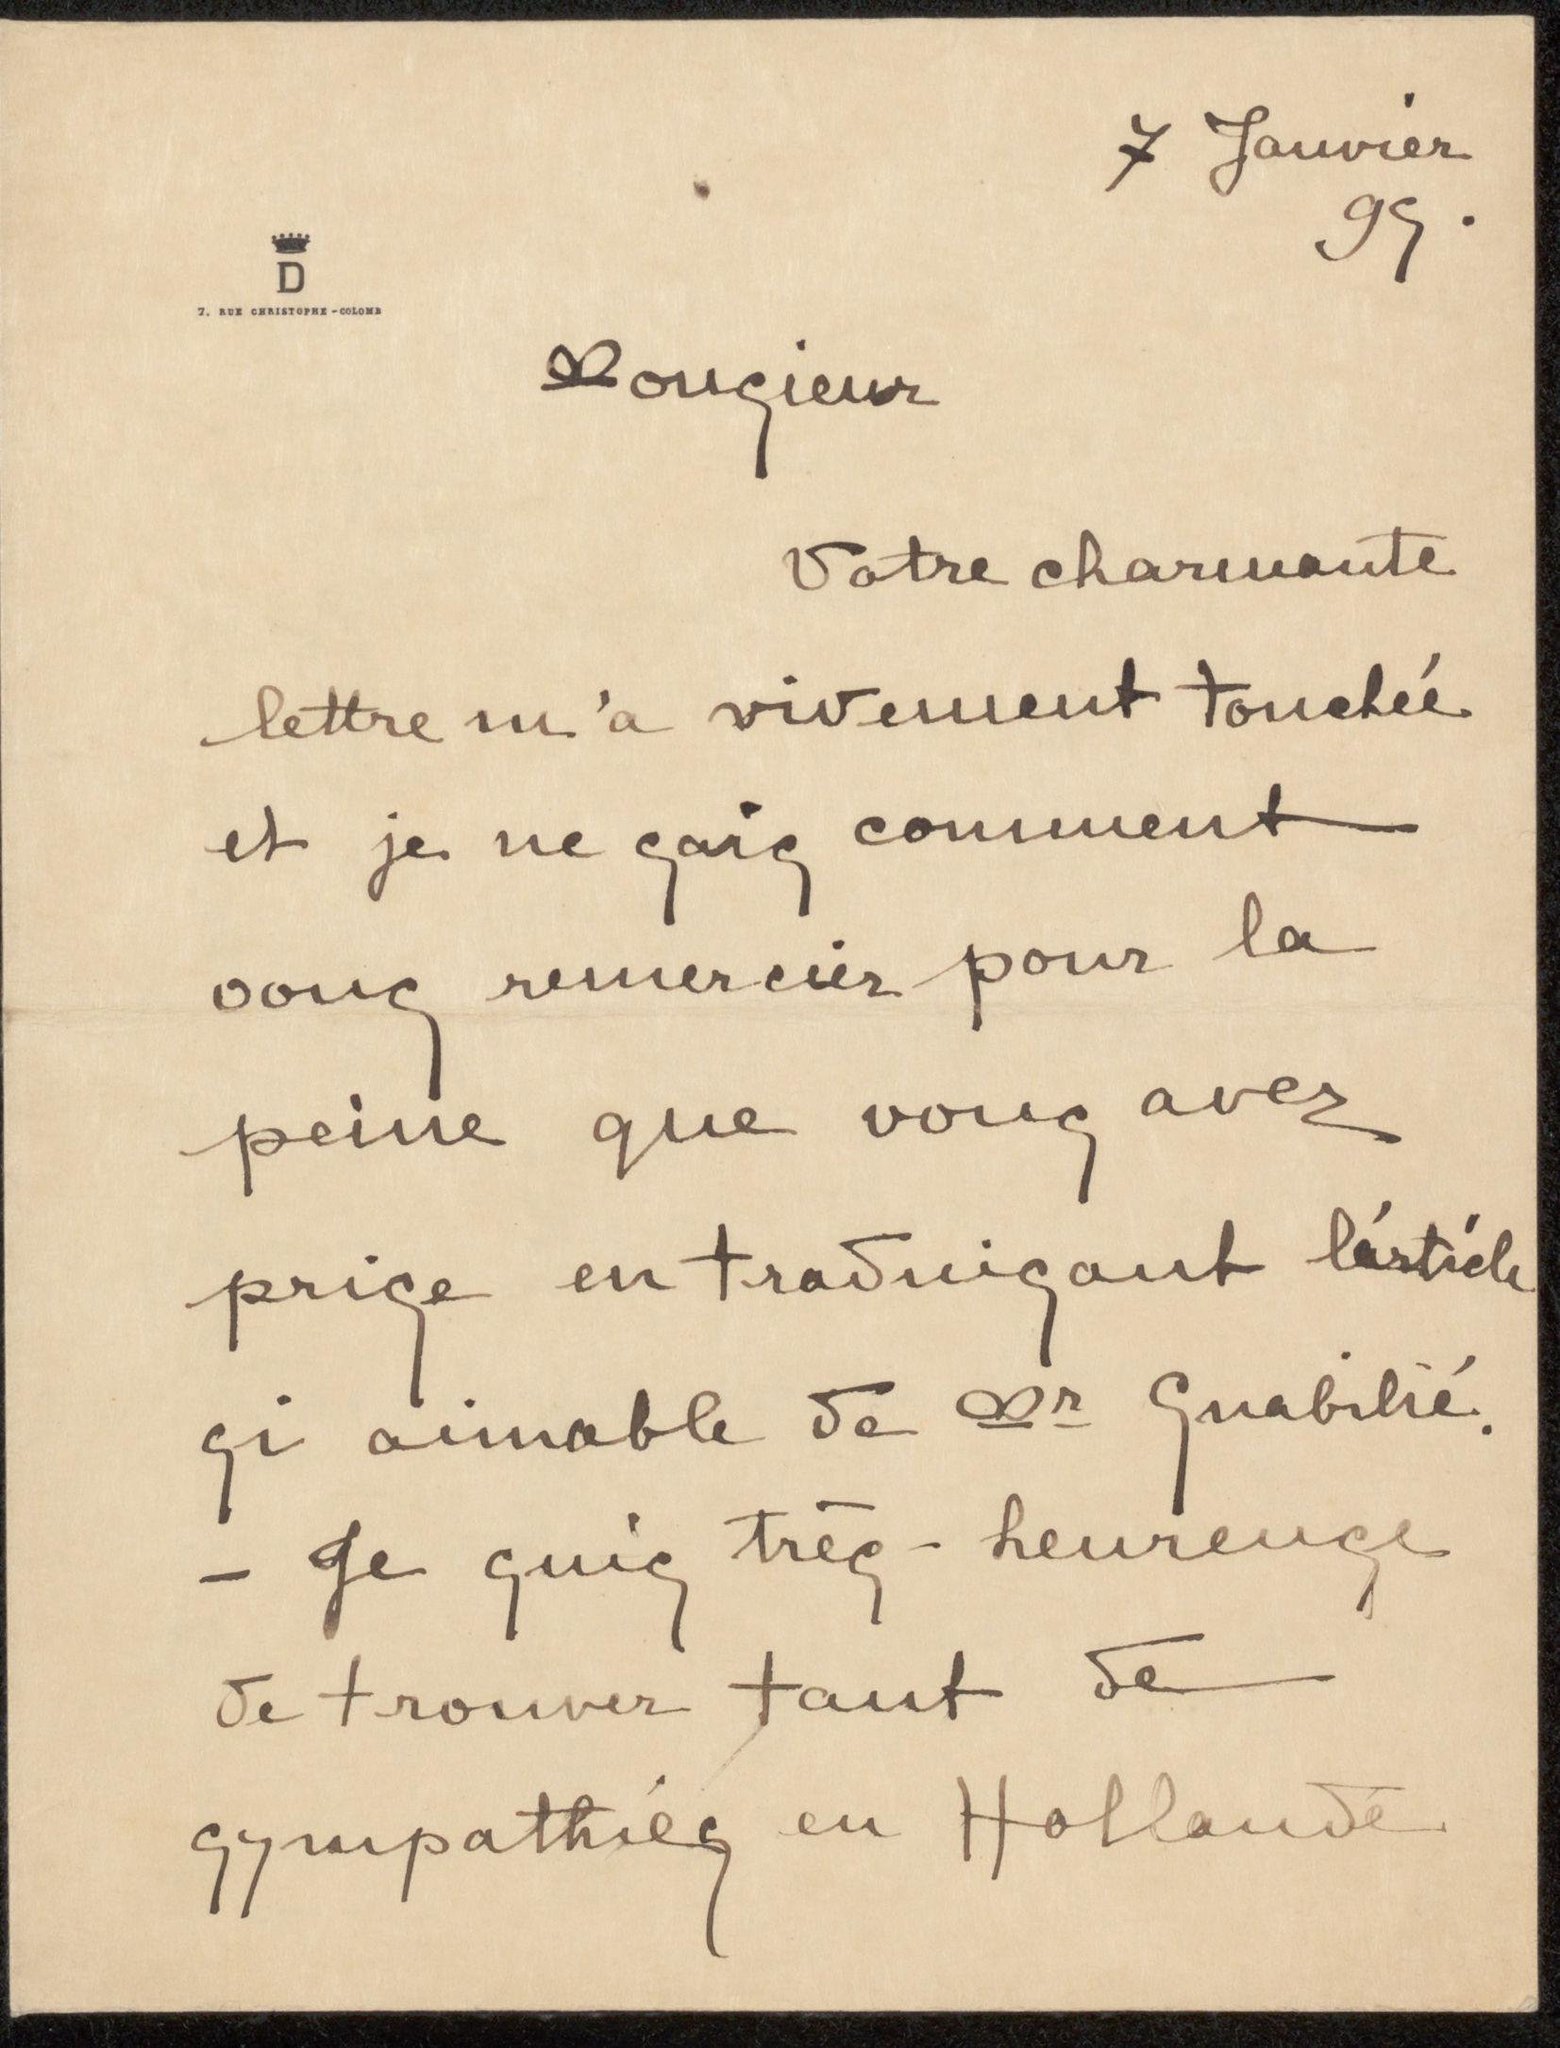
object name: letter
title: Brief aan Philip Zilcken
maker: baronne madeleine deslandes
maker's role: schrijver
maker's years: 1866-1929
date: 1895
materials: ink, paper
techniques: pen, writing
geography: paris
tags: charles snabilié, the hague, painter, draughtsman, philip zilcken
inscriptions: monogram: ‘D’, collector's mark: ‘RPK’, address: ‘7. RUE CHRISTOPHE-COLOMB’